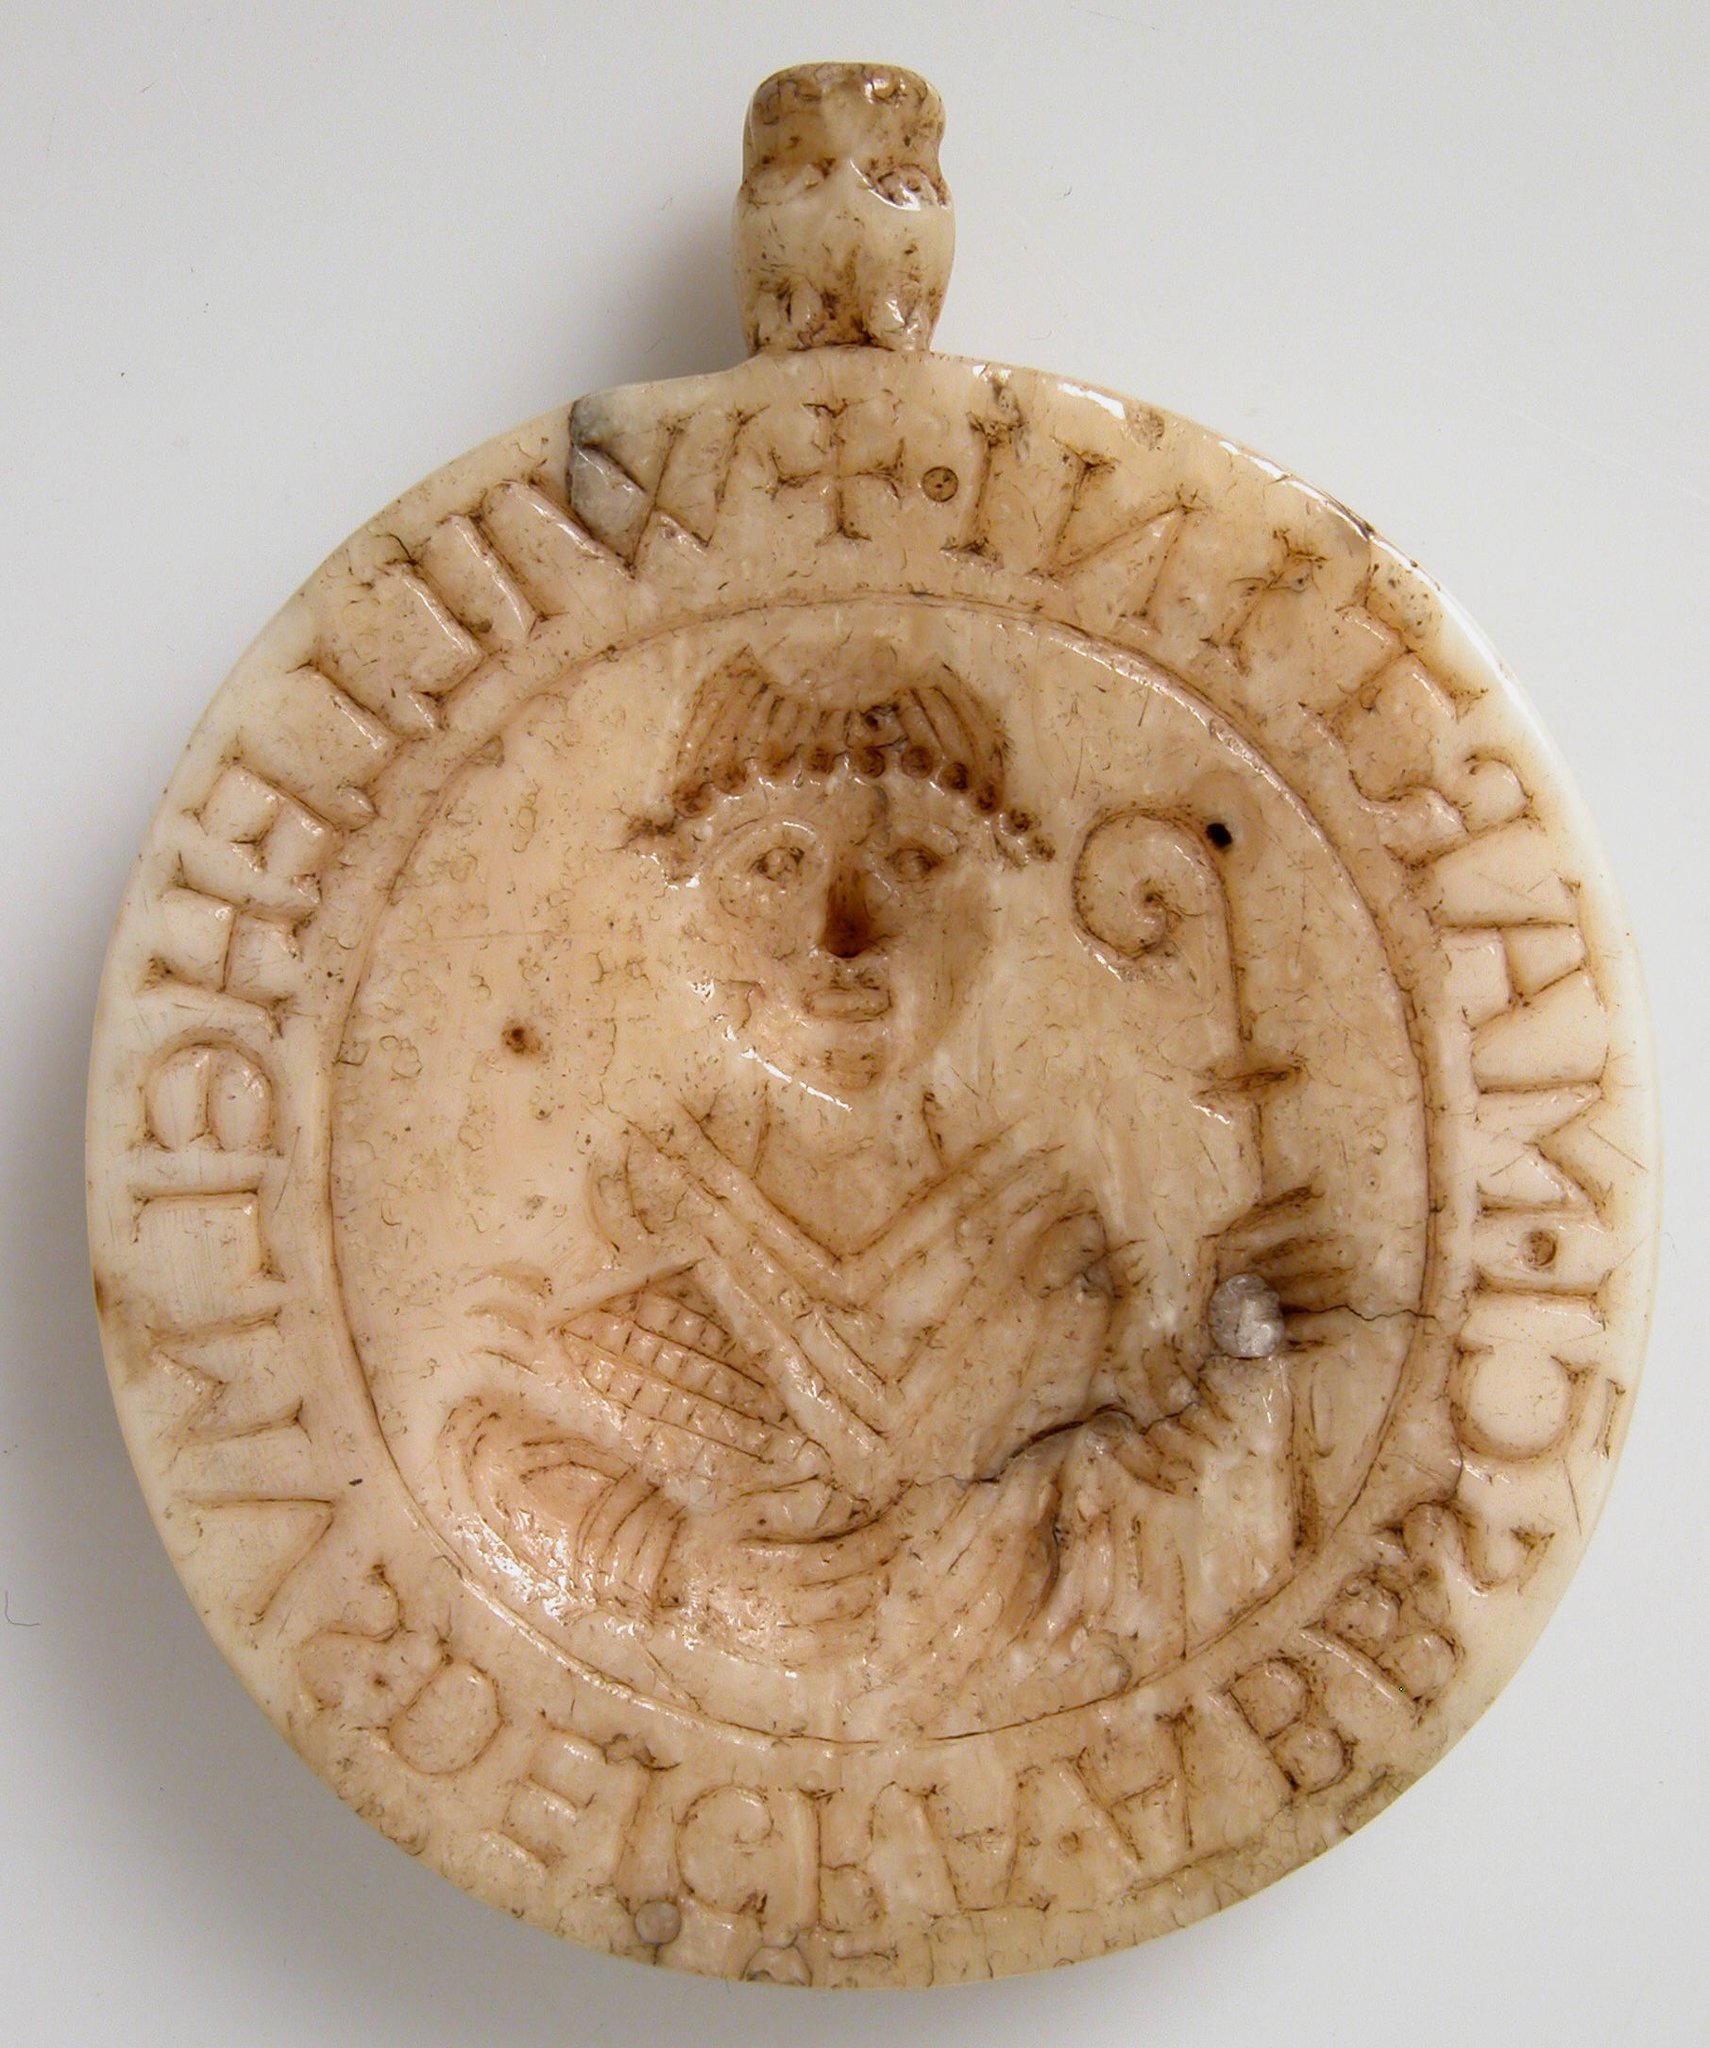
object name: seal matrix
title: Seal Matrix with Abbot William of Gross St. Martin and Saint Martin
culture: german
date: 1152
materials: ivory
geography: germany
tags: men,saints